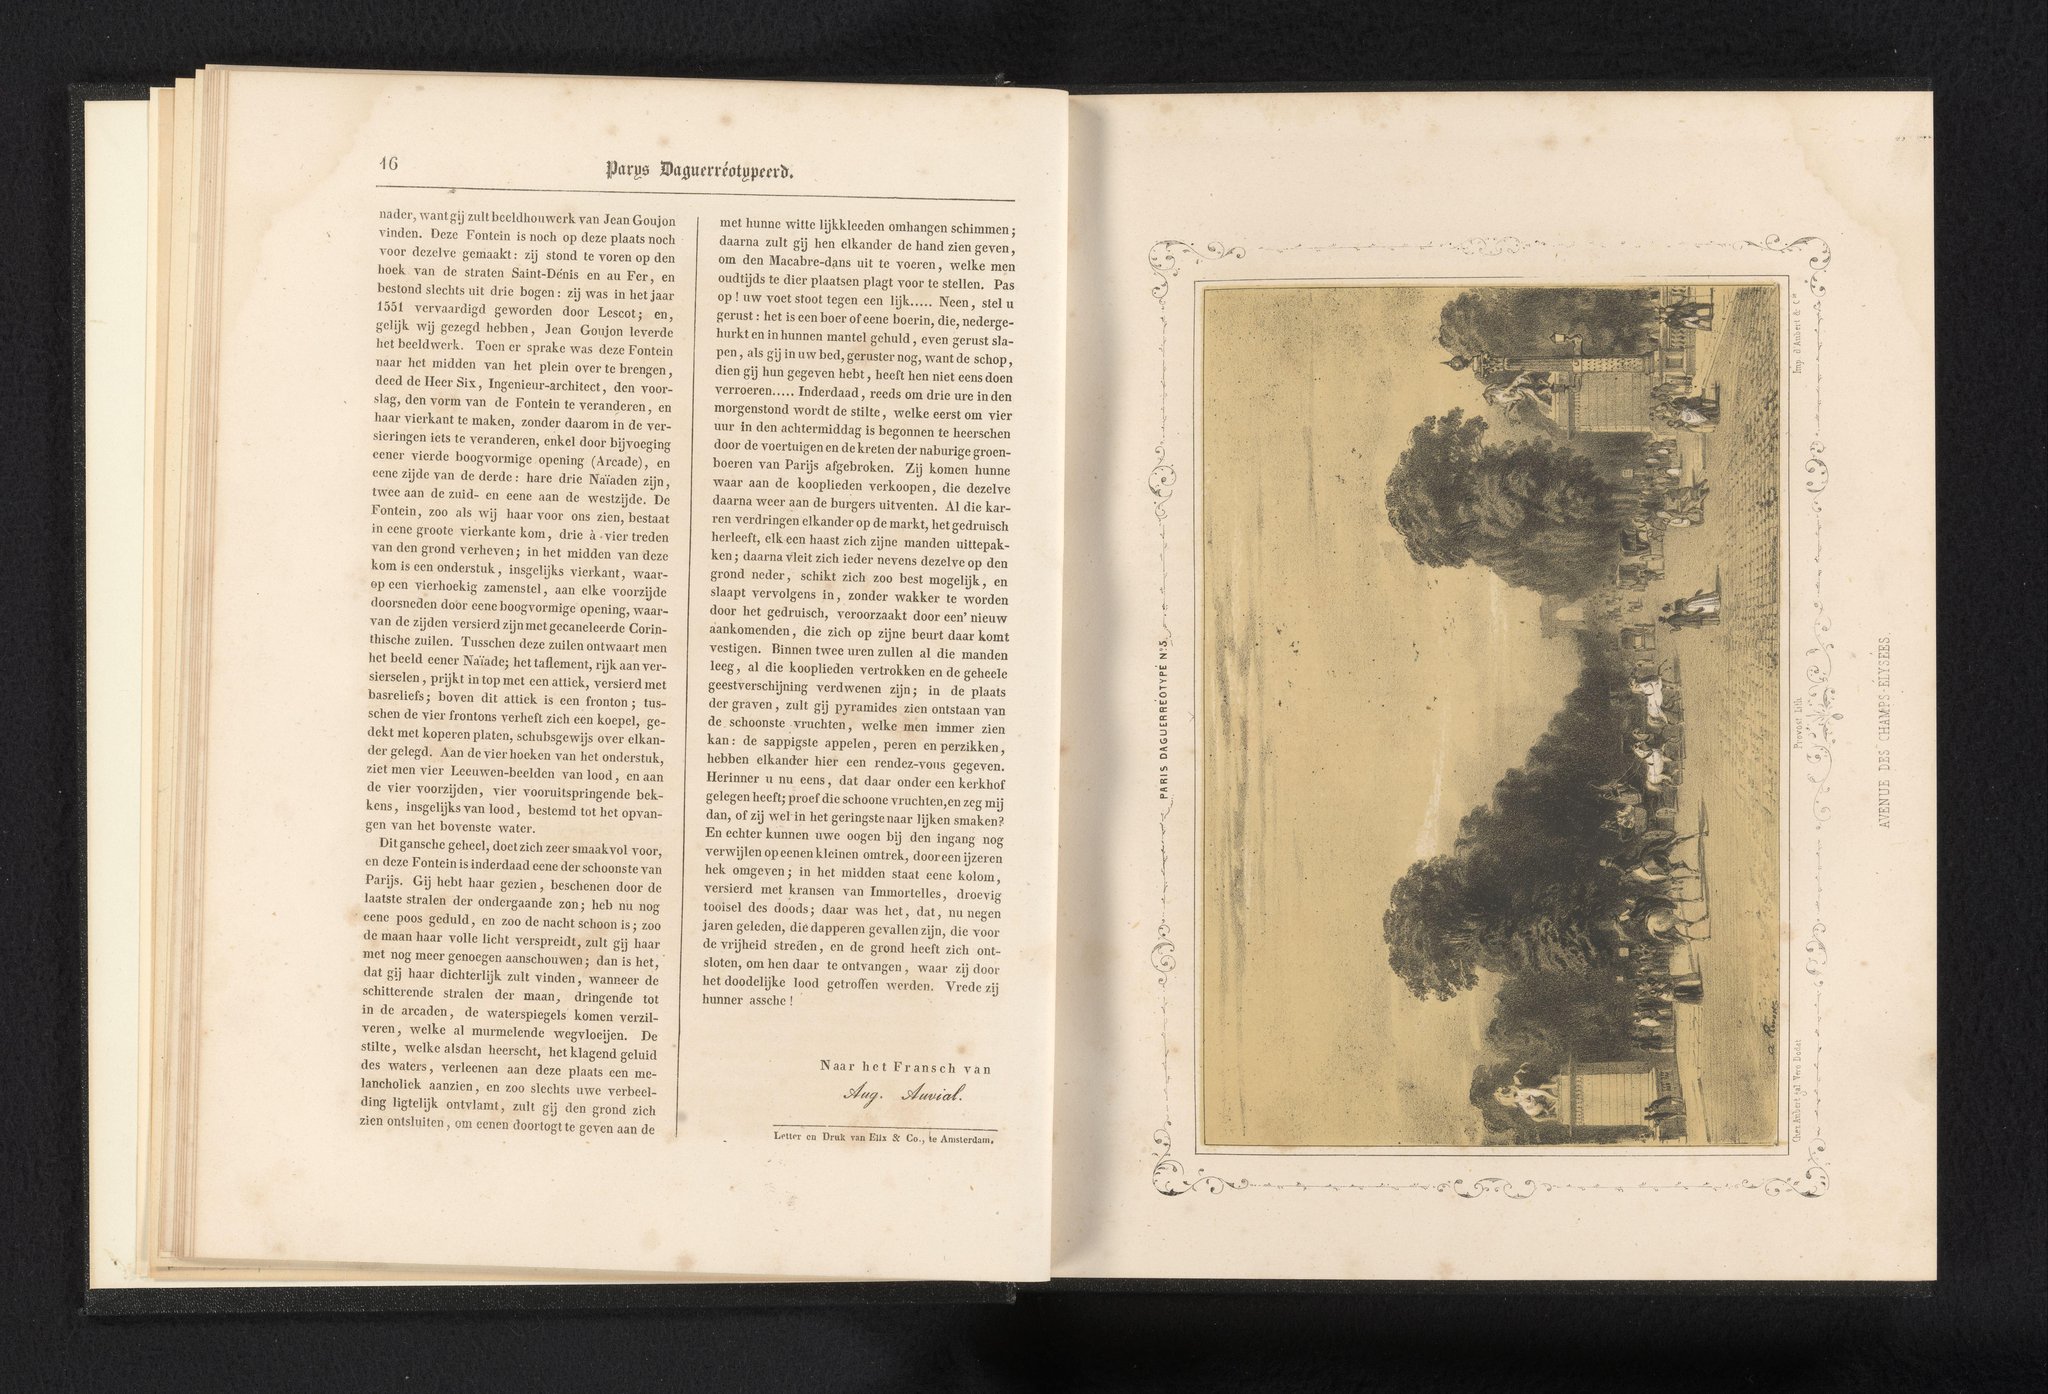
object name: print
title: Avenue des Champs-Élysées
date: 1839-1840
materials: paper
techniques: tone lithography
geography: paris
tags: avenue, boulevard, promenade, esplanade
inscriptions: inscription: ‘PARIS DAGUERRÉOTYPÉ No. 5.’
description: Prent op zeventiende ongenummerde pagina.